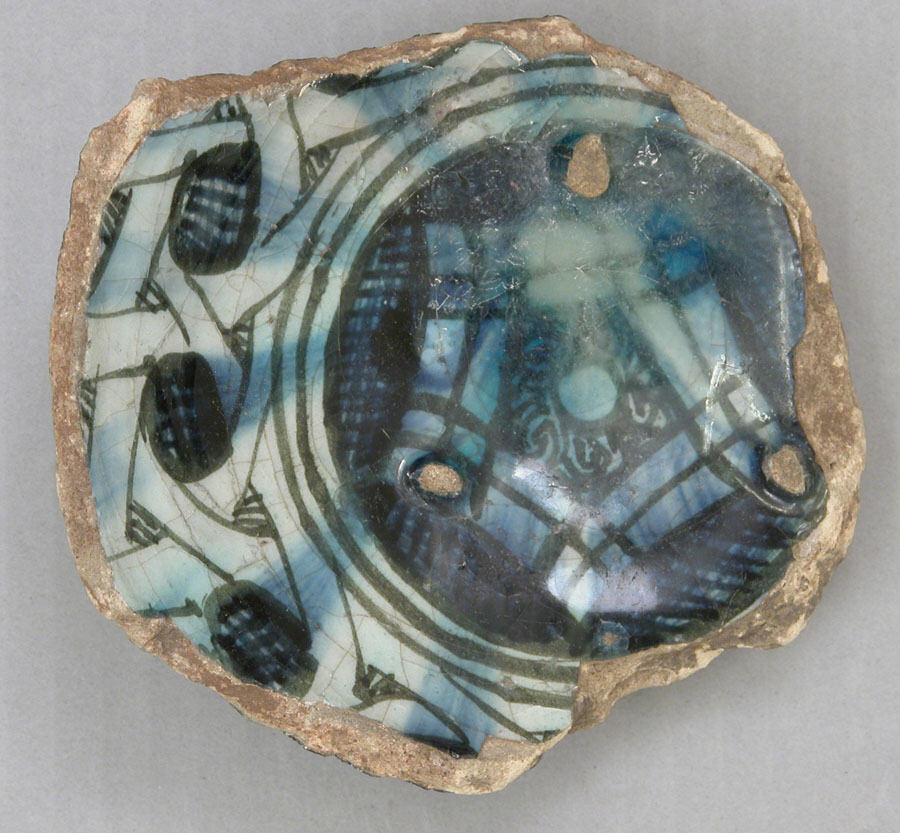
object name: fragment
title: Fragment of a Bowl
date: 1301-1500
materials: glaze, stonepaste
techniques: painting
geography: egypt